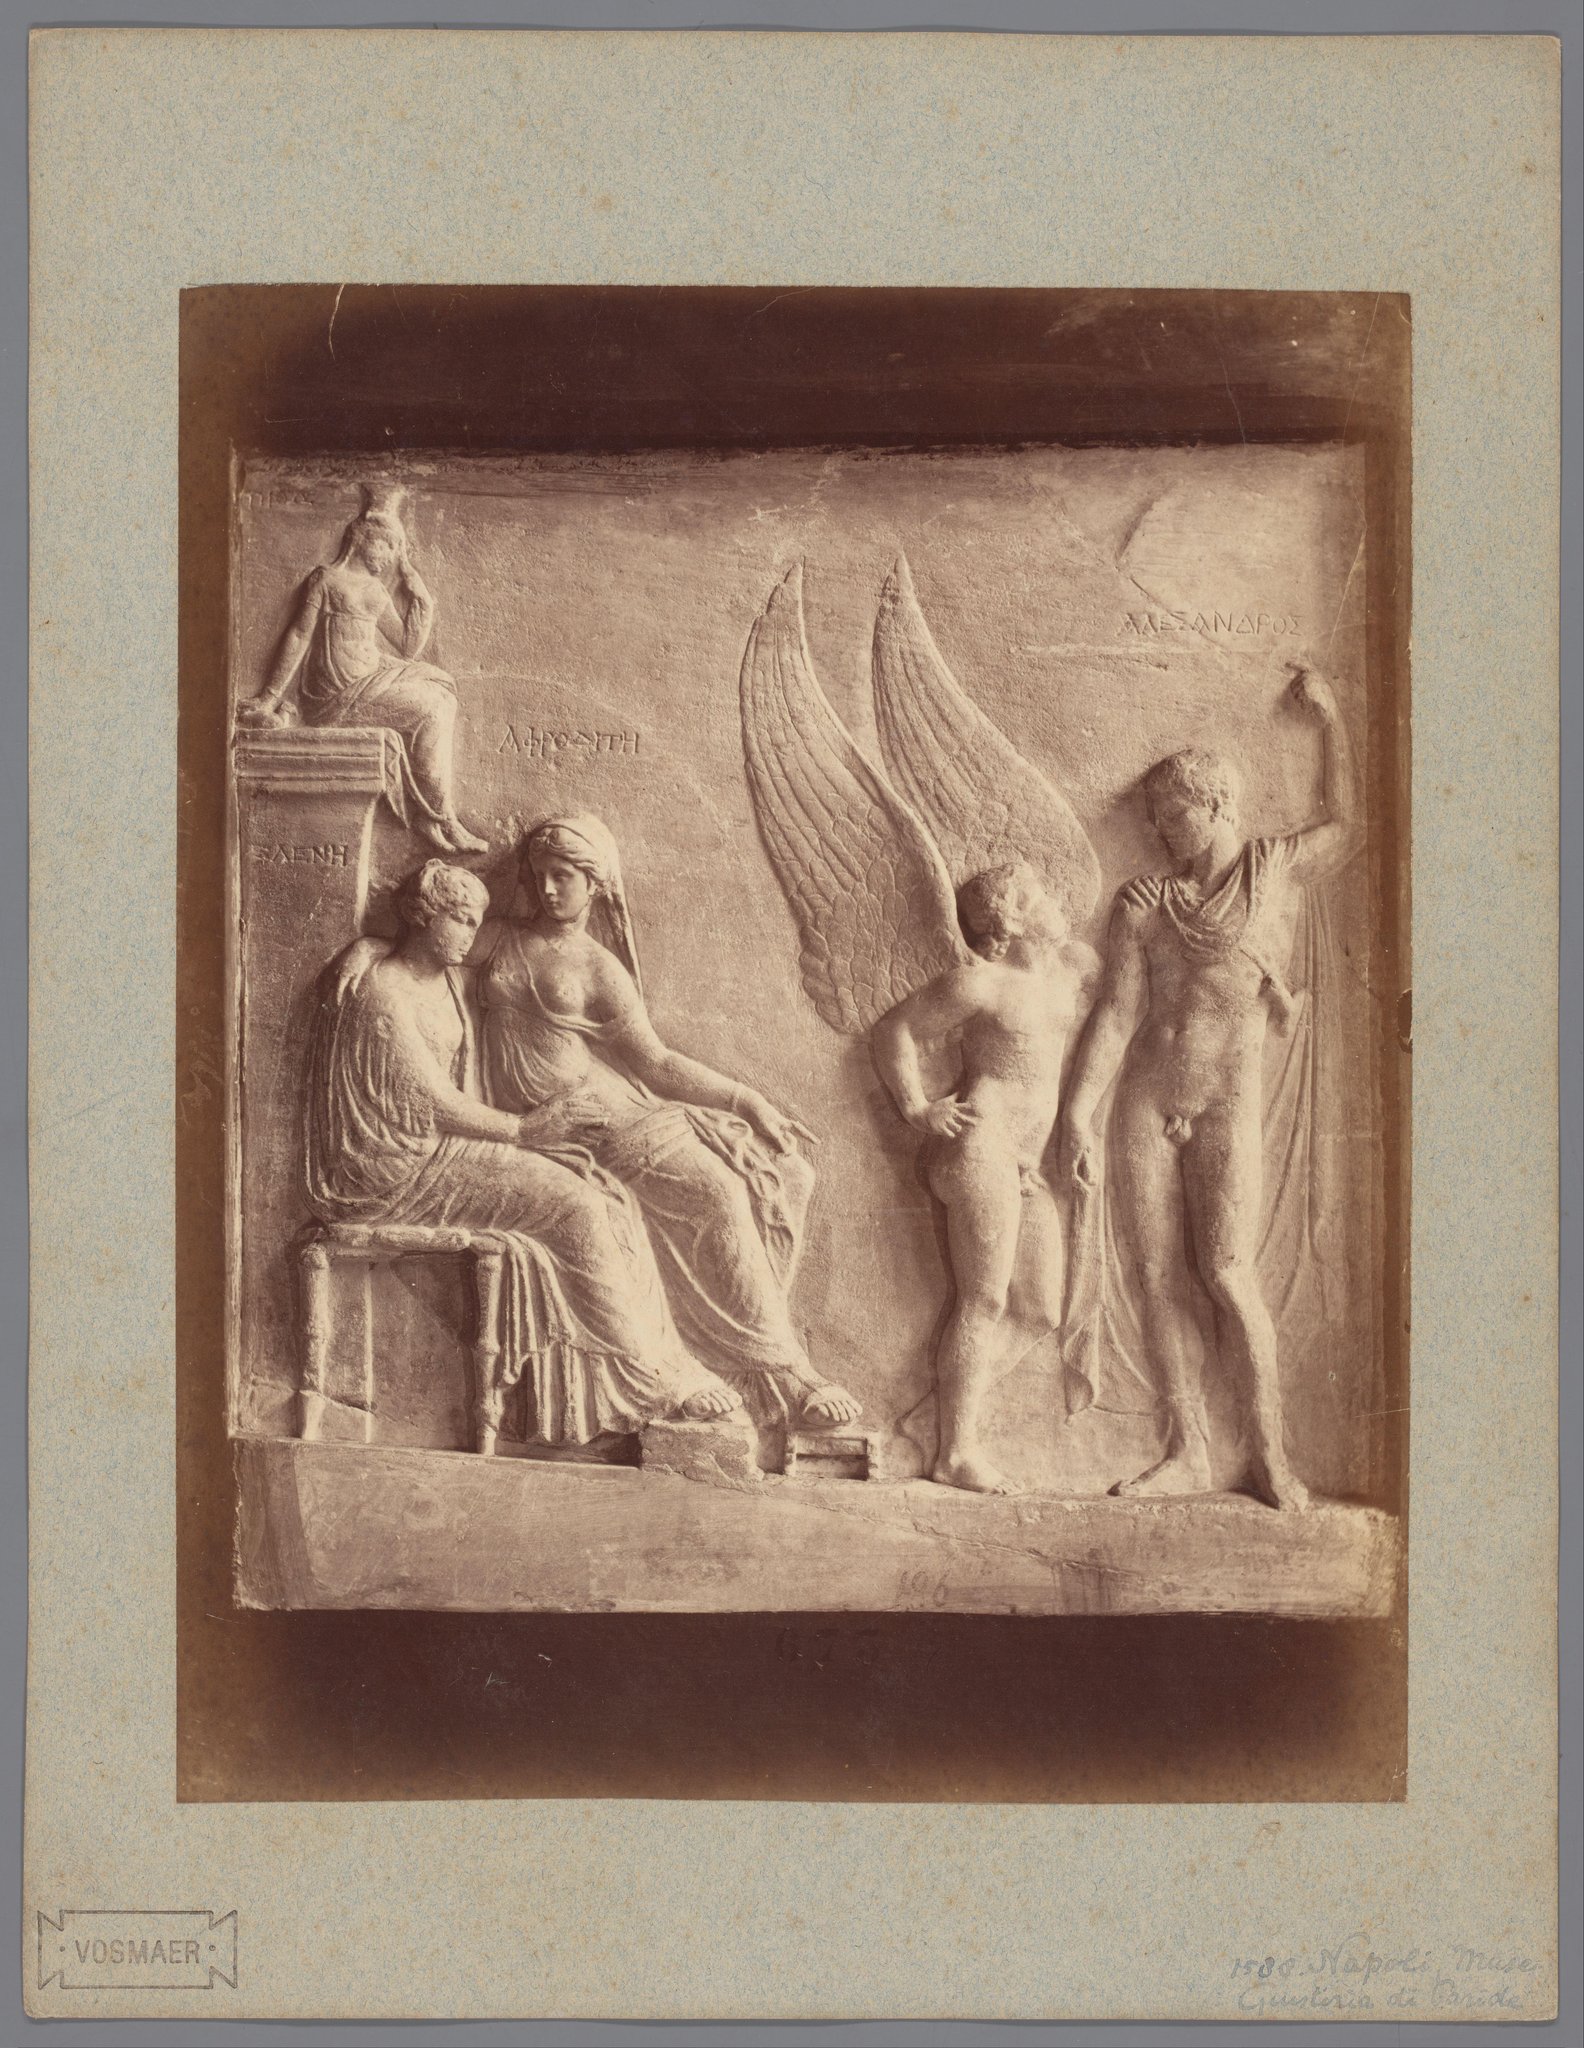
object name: photograph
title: Napoli Museo Giudizio di Paride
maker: giorgio sommer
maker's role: fotograaf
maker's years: 1834-1914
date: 1857-1914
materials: cardboard, paper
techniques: albumen print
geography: naples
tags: the abduction of helen and some of her companions: paris carries them off by sea, and takes a part of the palace-treasure with him, piece of sculpture, reproduction of a piece of sculpture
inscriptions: inscription: ‘Sommer (t)’, inscription: ‘10’, number: ‘1588.’, collector's mark: ‘VOSMAER’